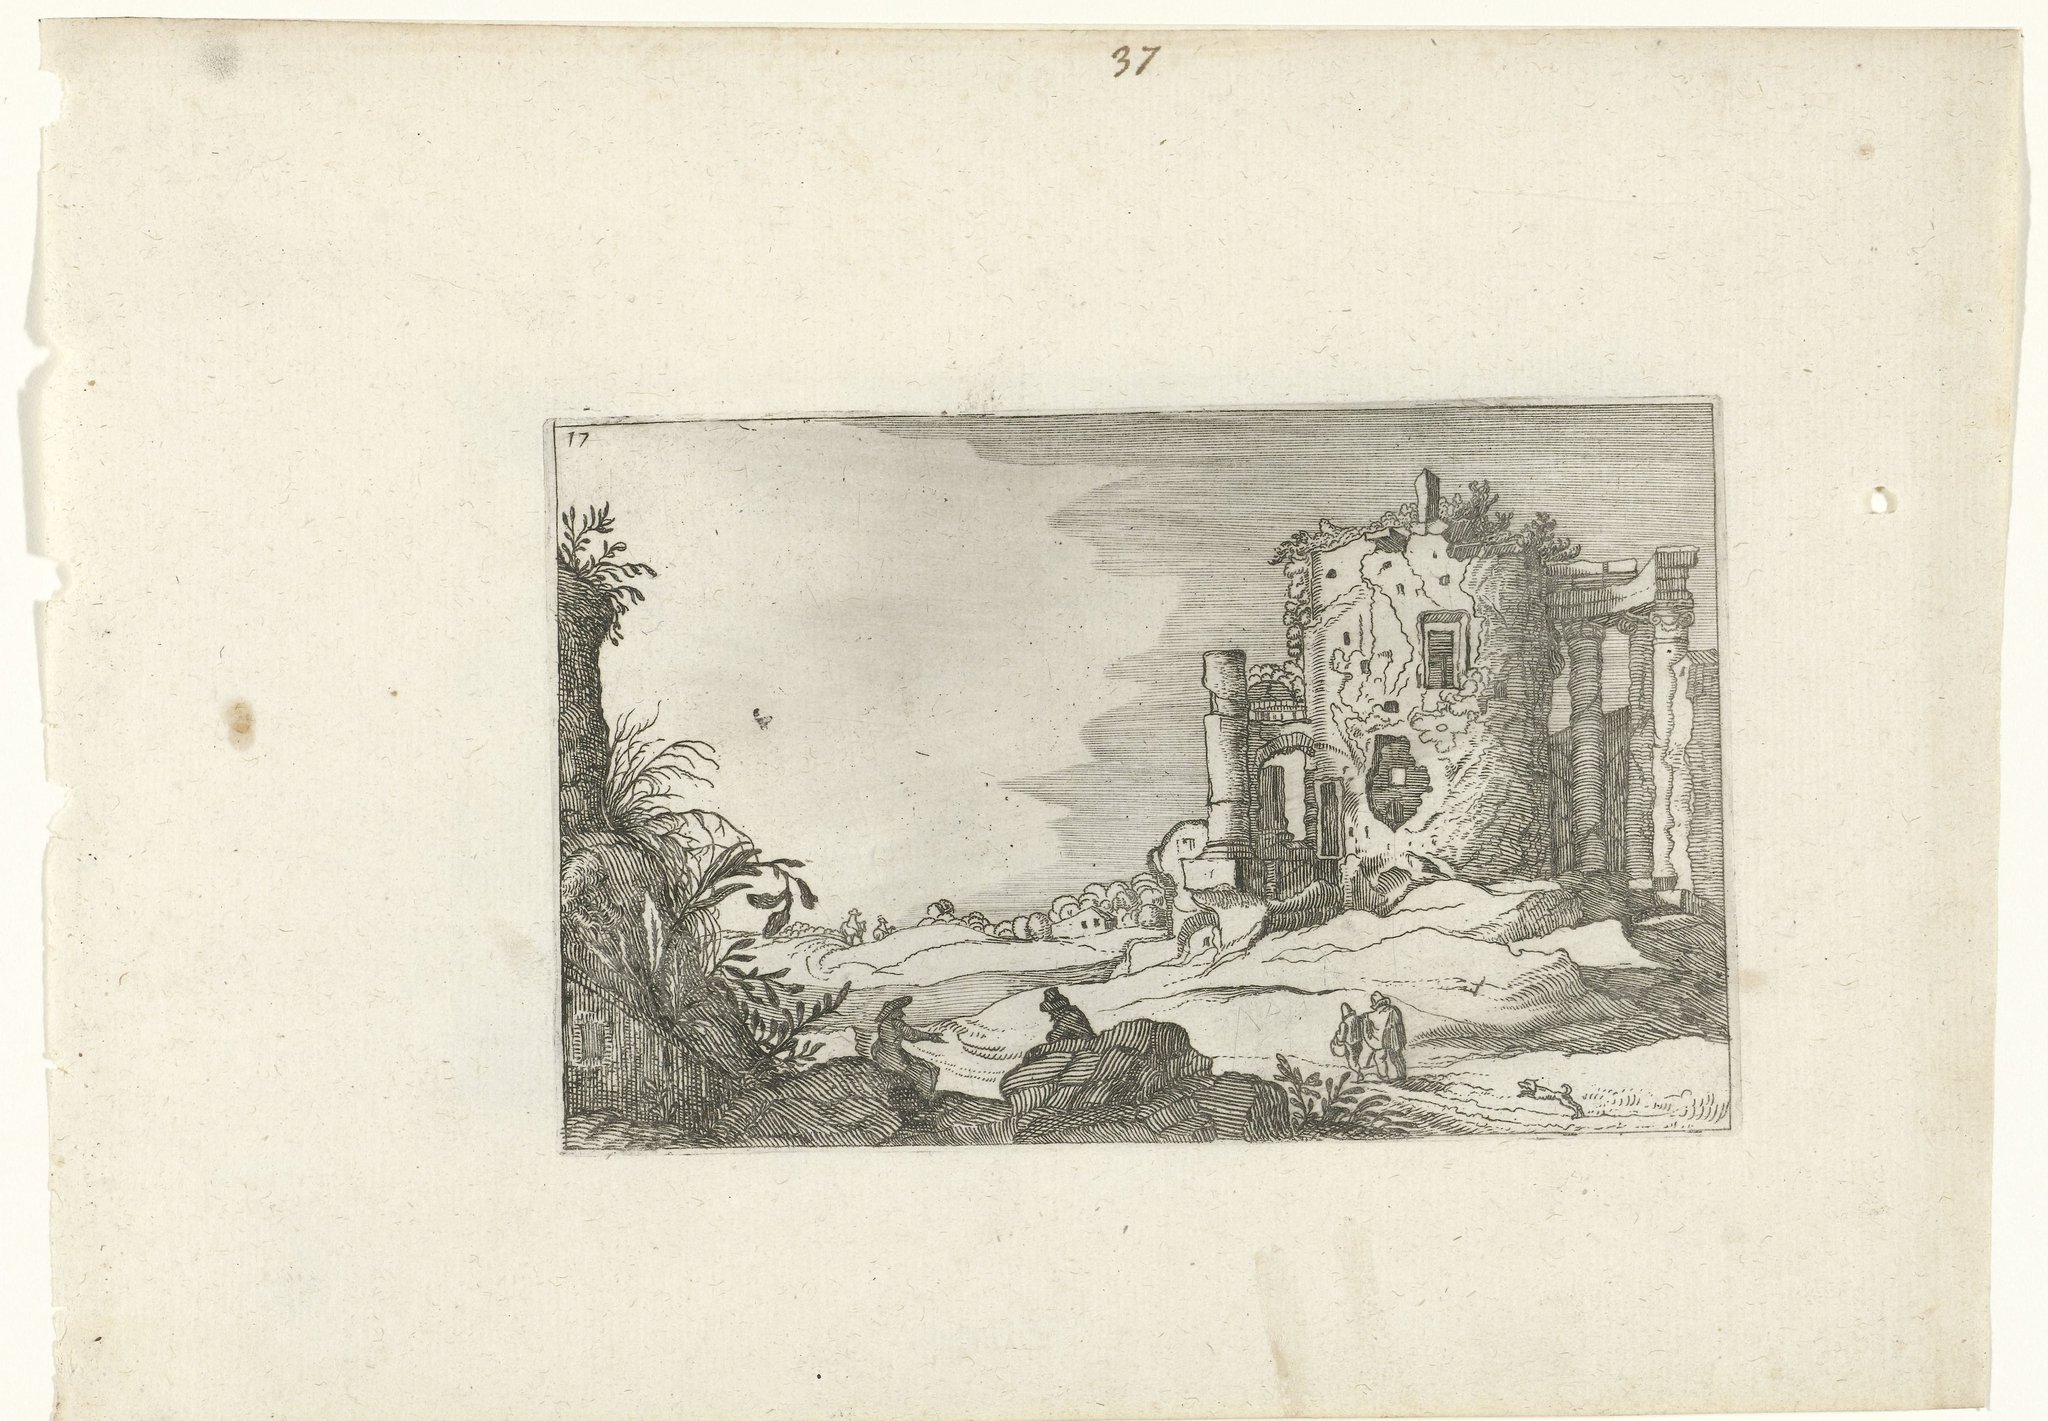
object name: print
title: Ruïne van een door zuilen omgeven tempel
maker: Anonymous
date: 1594-1685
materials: paper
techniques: etching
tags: landscape with ruins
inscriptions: inscription: ‘37’, collector's mark: Lugt 2228, collector's mark: Lugt 2760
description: Een ruïne van een door zuilen omgeven tempel in een landschap. Op de voorgrond twee figuren en een hond op de weg en twee zittende figuren. Prent maakt deel uit van een serie Romeinse ruïnes en kustlandschappen naar prenten van Willem van Nieulandt. Deze serie is een kopie van de serie, die Claes Jansz Visscher naar Van Nieulandt maakte.